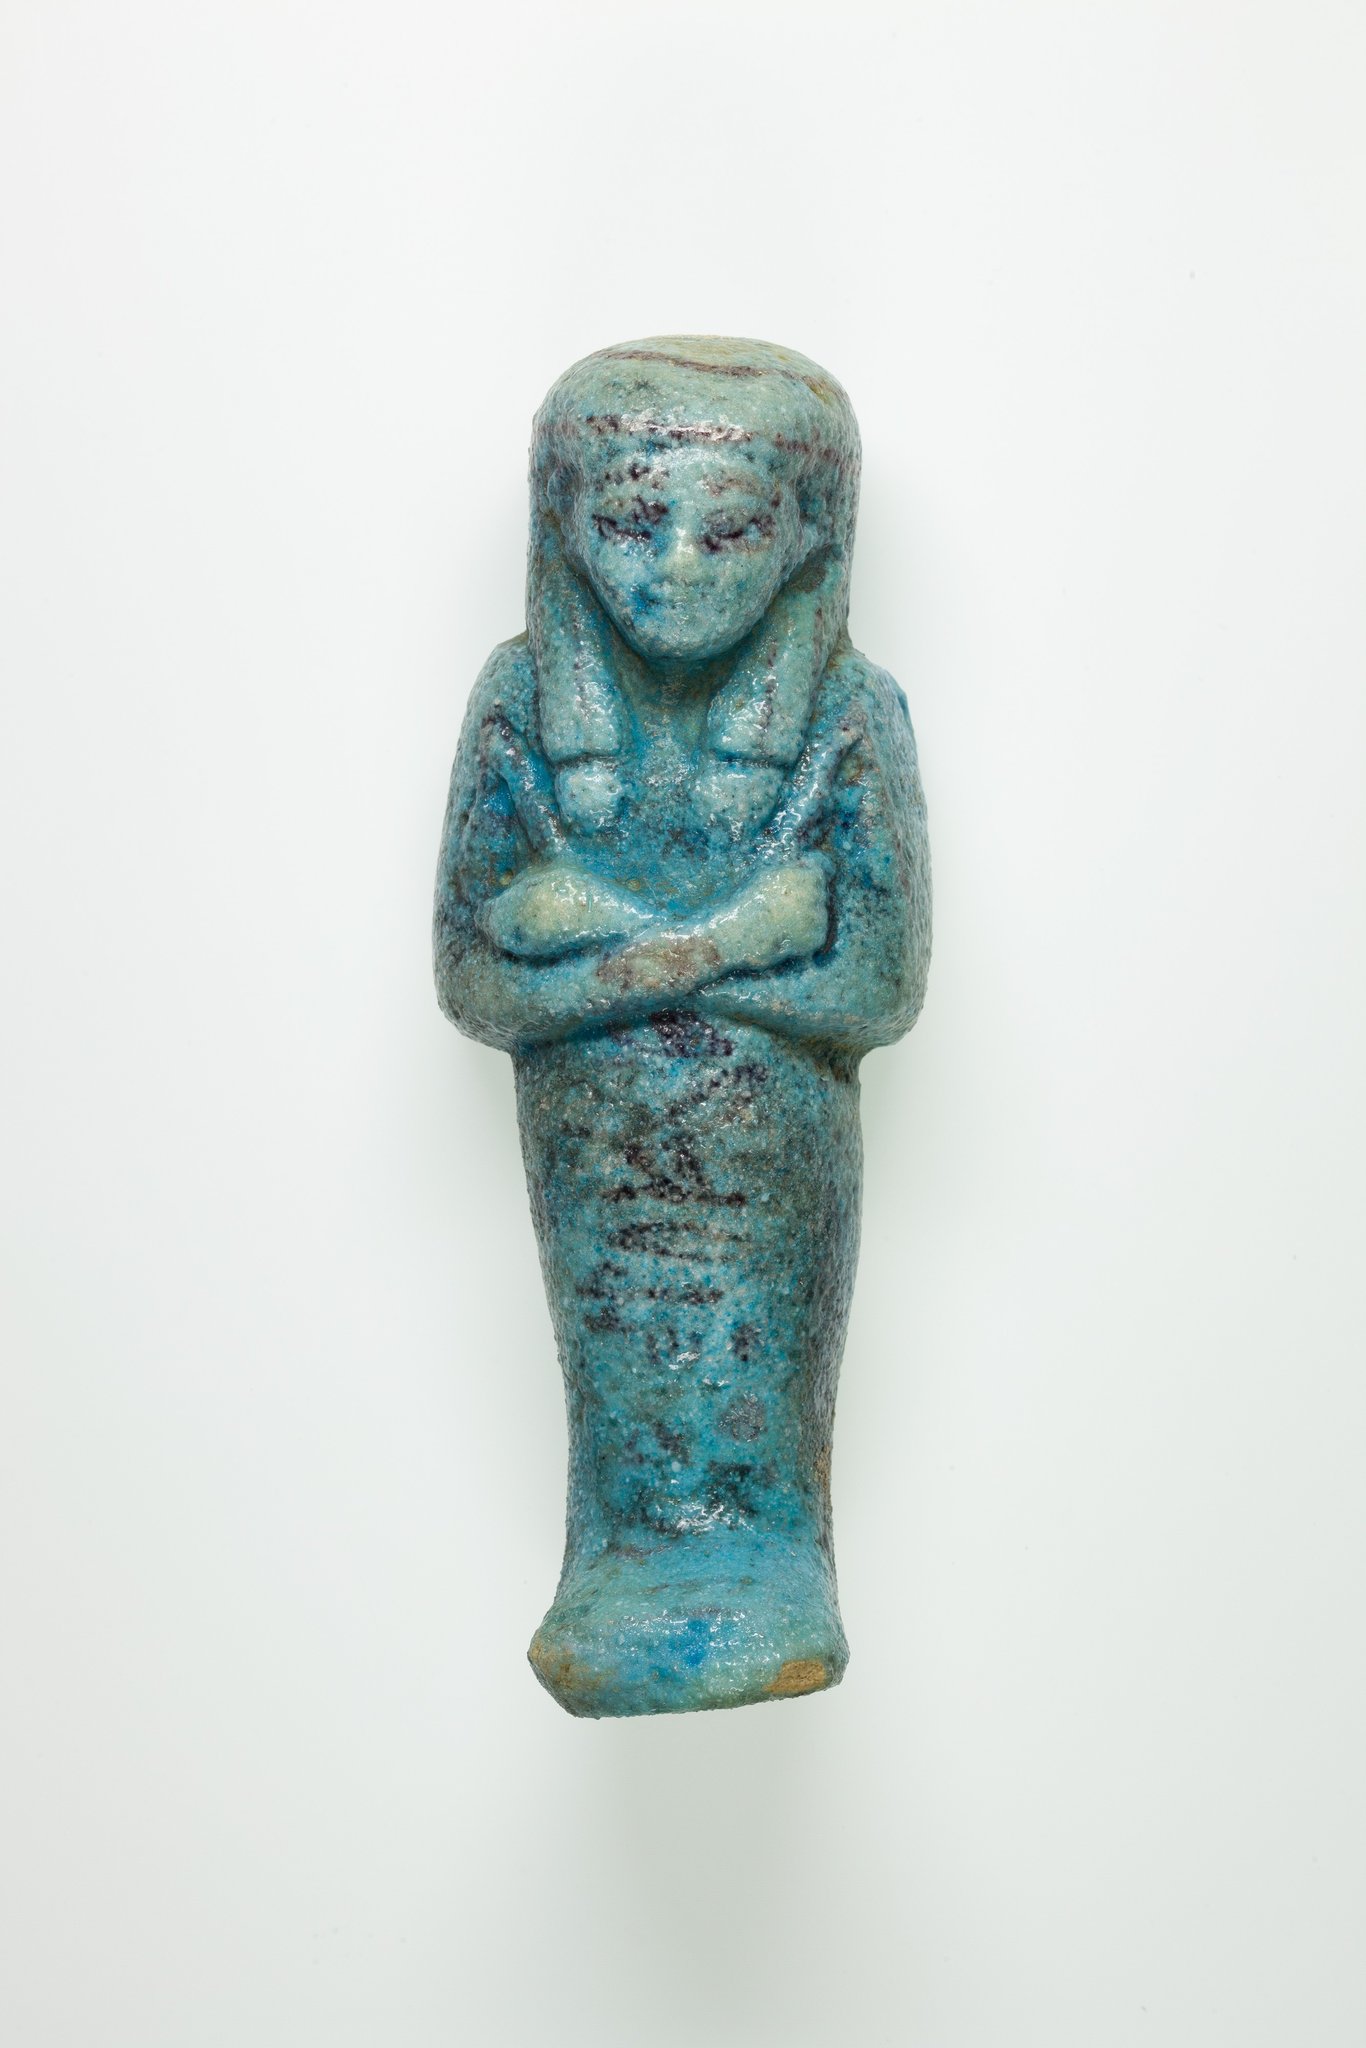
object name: worker shabti, henettawy c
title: Worker Shabti of Henettawy (C), Daughter of Isetemkheb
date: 990-970 BCE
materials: faience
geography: egypt